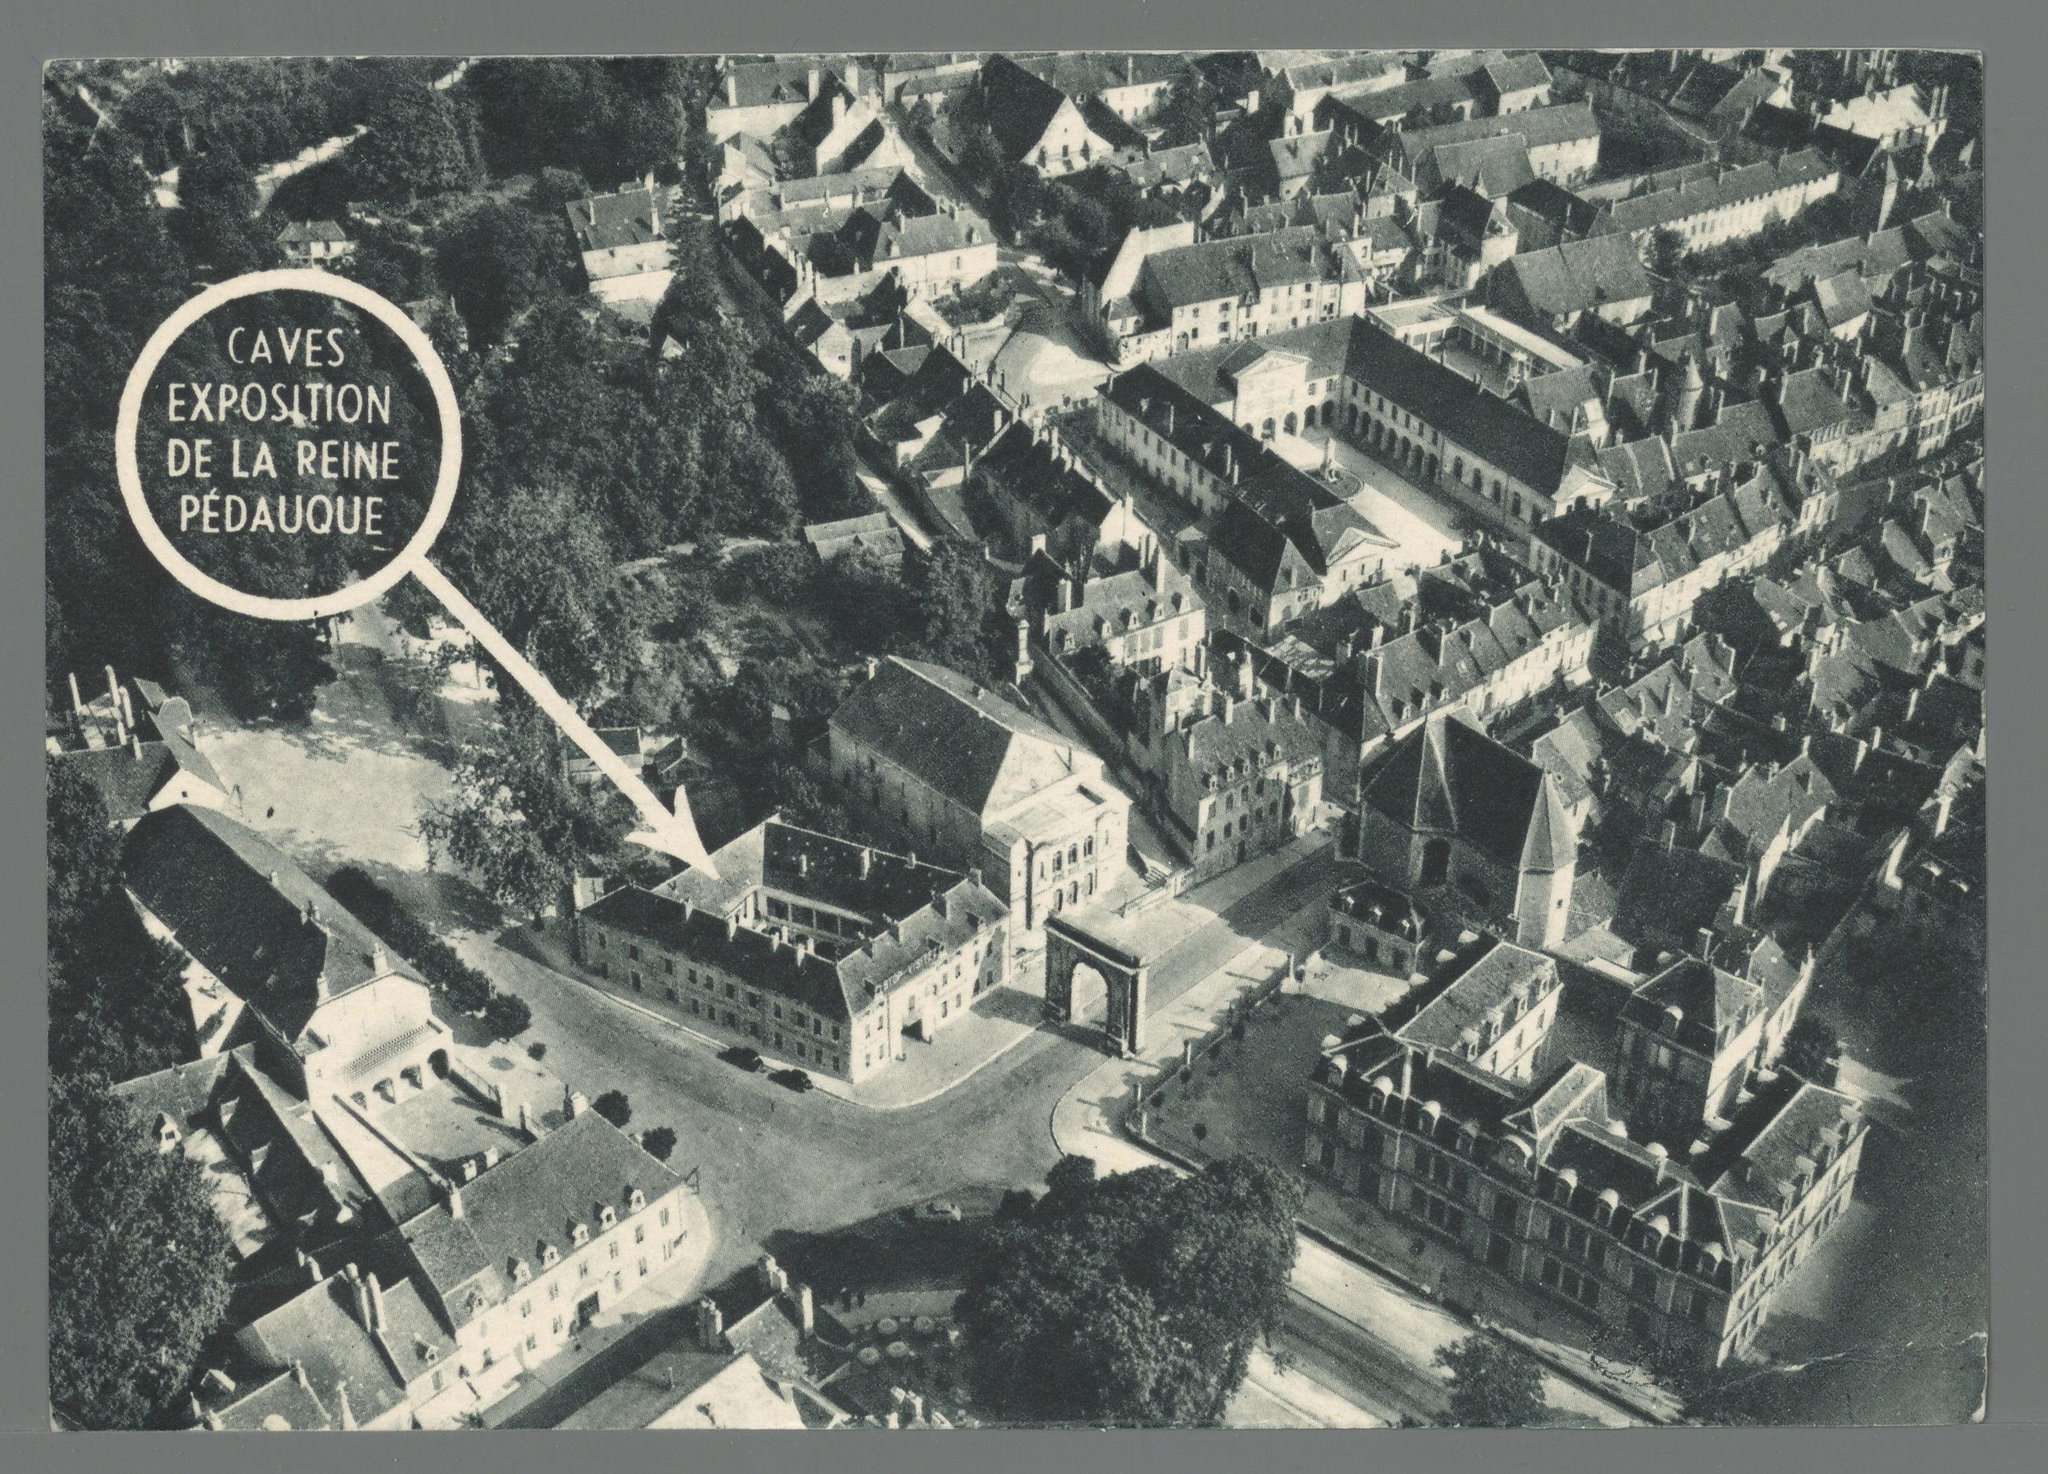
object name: ansichtkaart, prentbriefkaart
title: Vue aérienne de Beaune et des Caves-Exposition de la Rotisserie de la Reine Pédauque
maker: Anonymous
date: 1950-1982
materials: cardboard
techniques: rotogravure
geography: mâcon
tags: urban housing, prospect of city, town panorama, silhouette of city